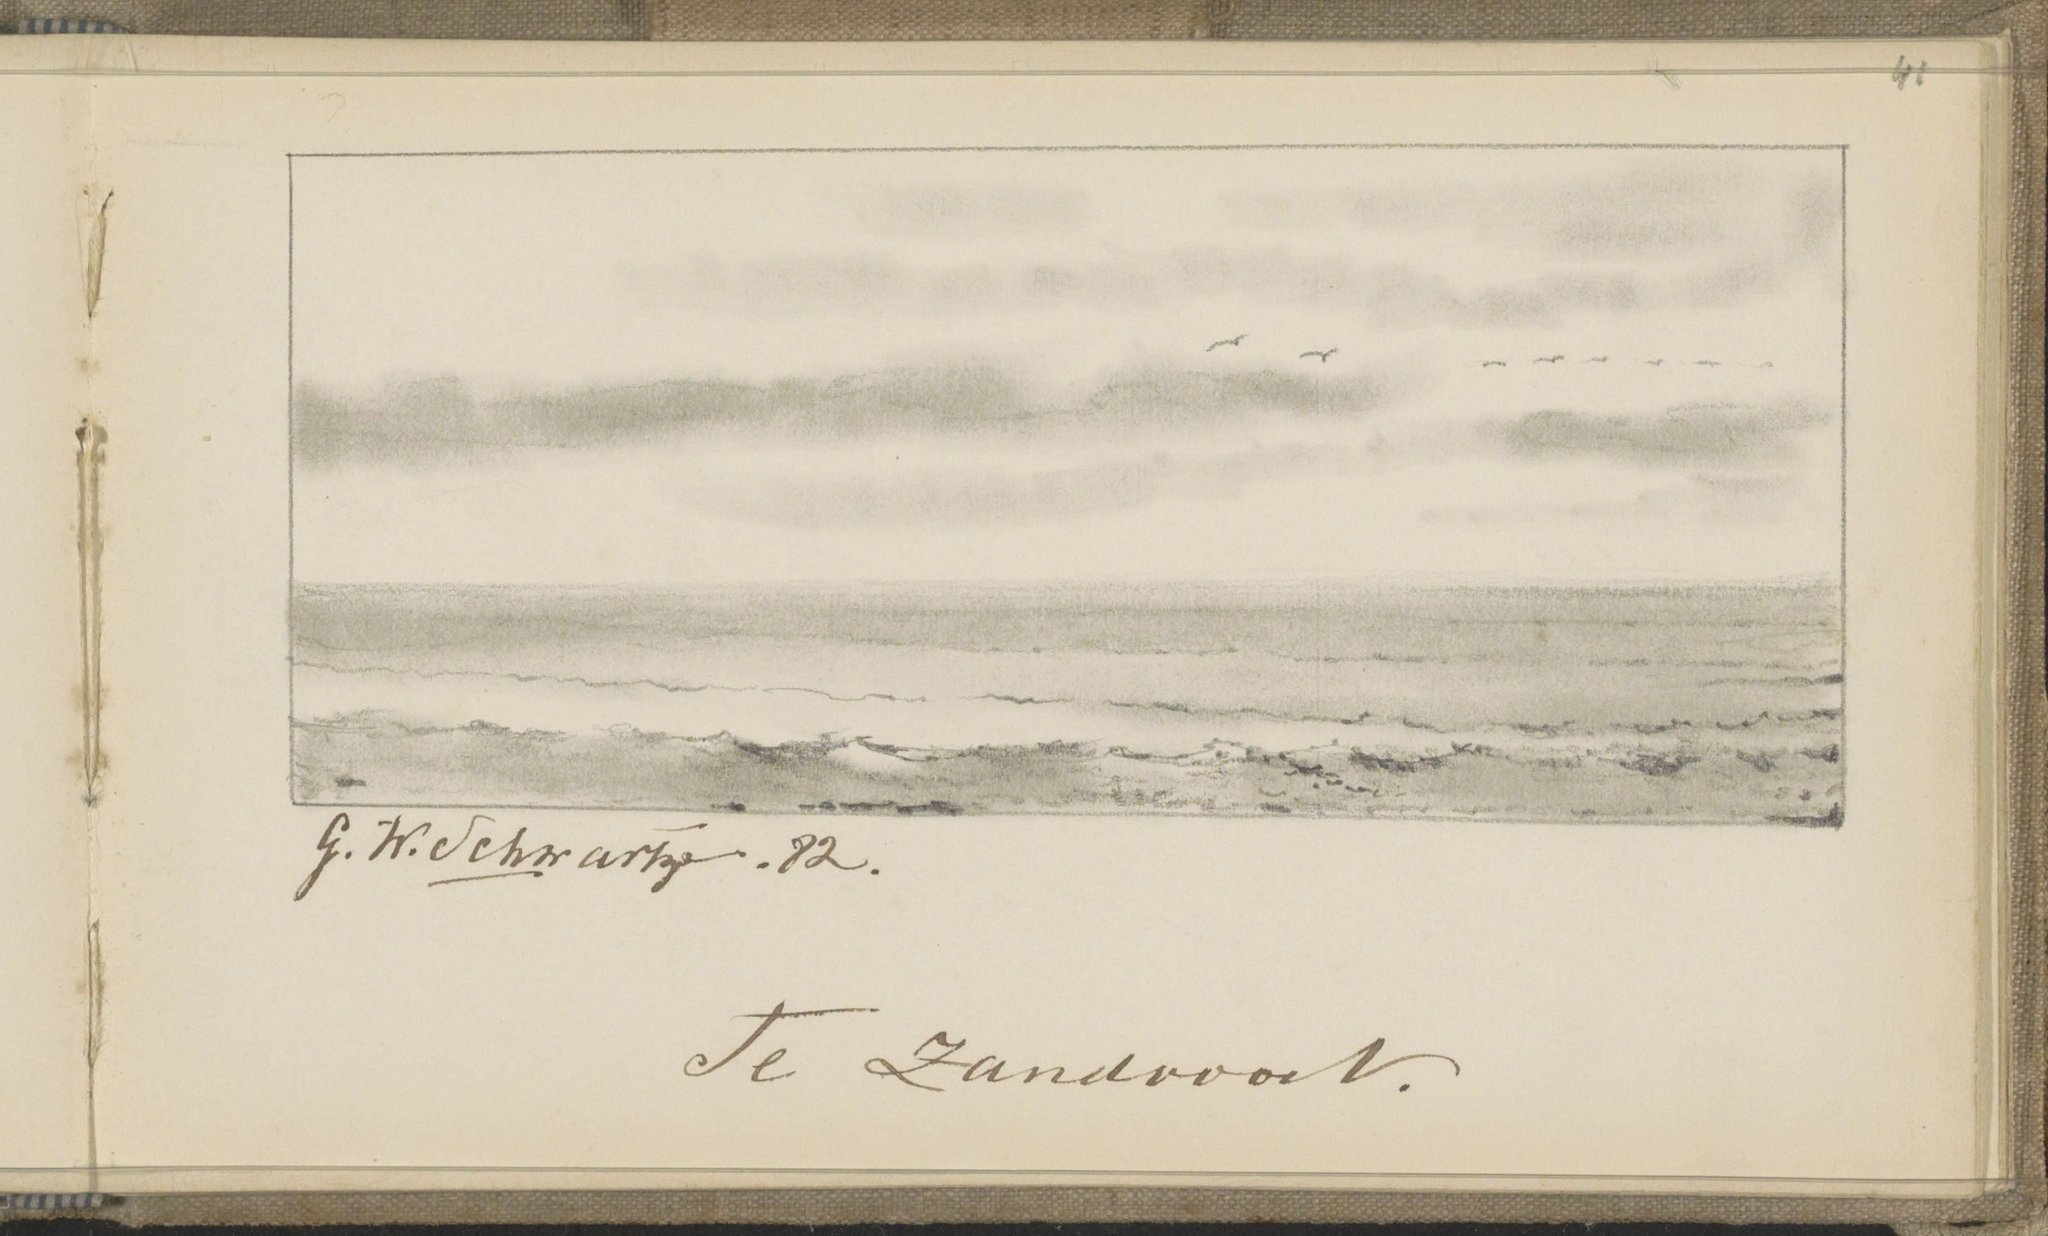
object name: sketchbook leaf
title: Te Zandvoort.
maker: george washington schwartze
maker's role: draughtsman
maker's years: 1857-1909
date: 1882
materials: paper, pencil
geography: zandvoort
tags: landscapes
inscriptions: title: ‘Te Zandvoort.’, signature and date: ‘G.W. Schwartze .82.’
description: Tekening in een kader. Blad 41 recto uit een schetsboek met 54 bladen.